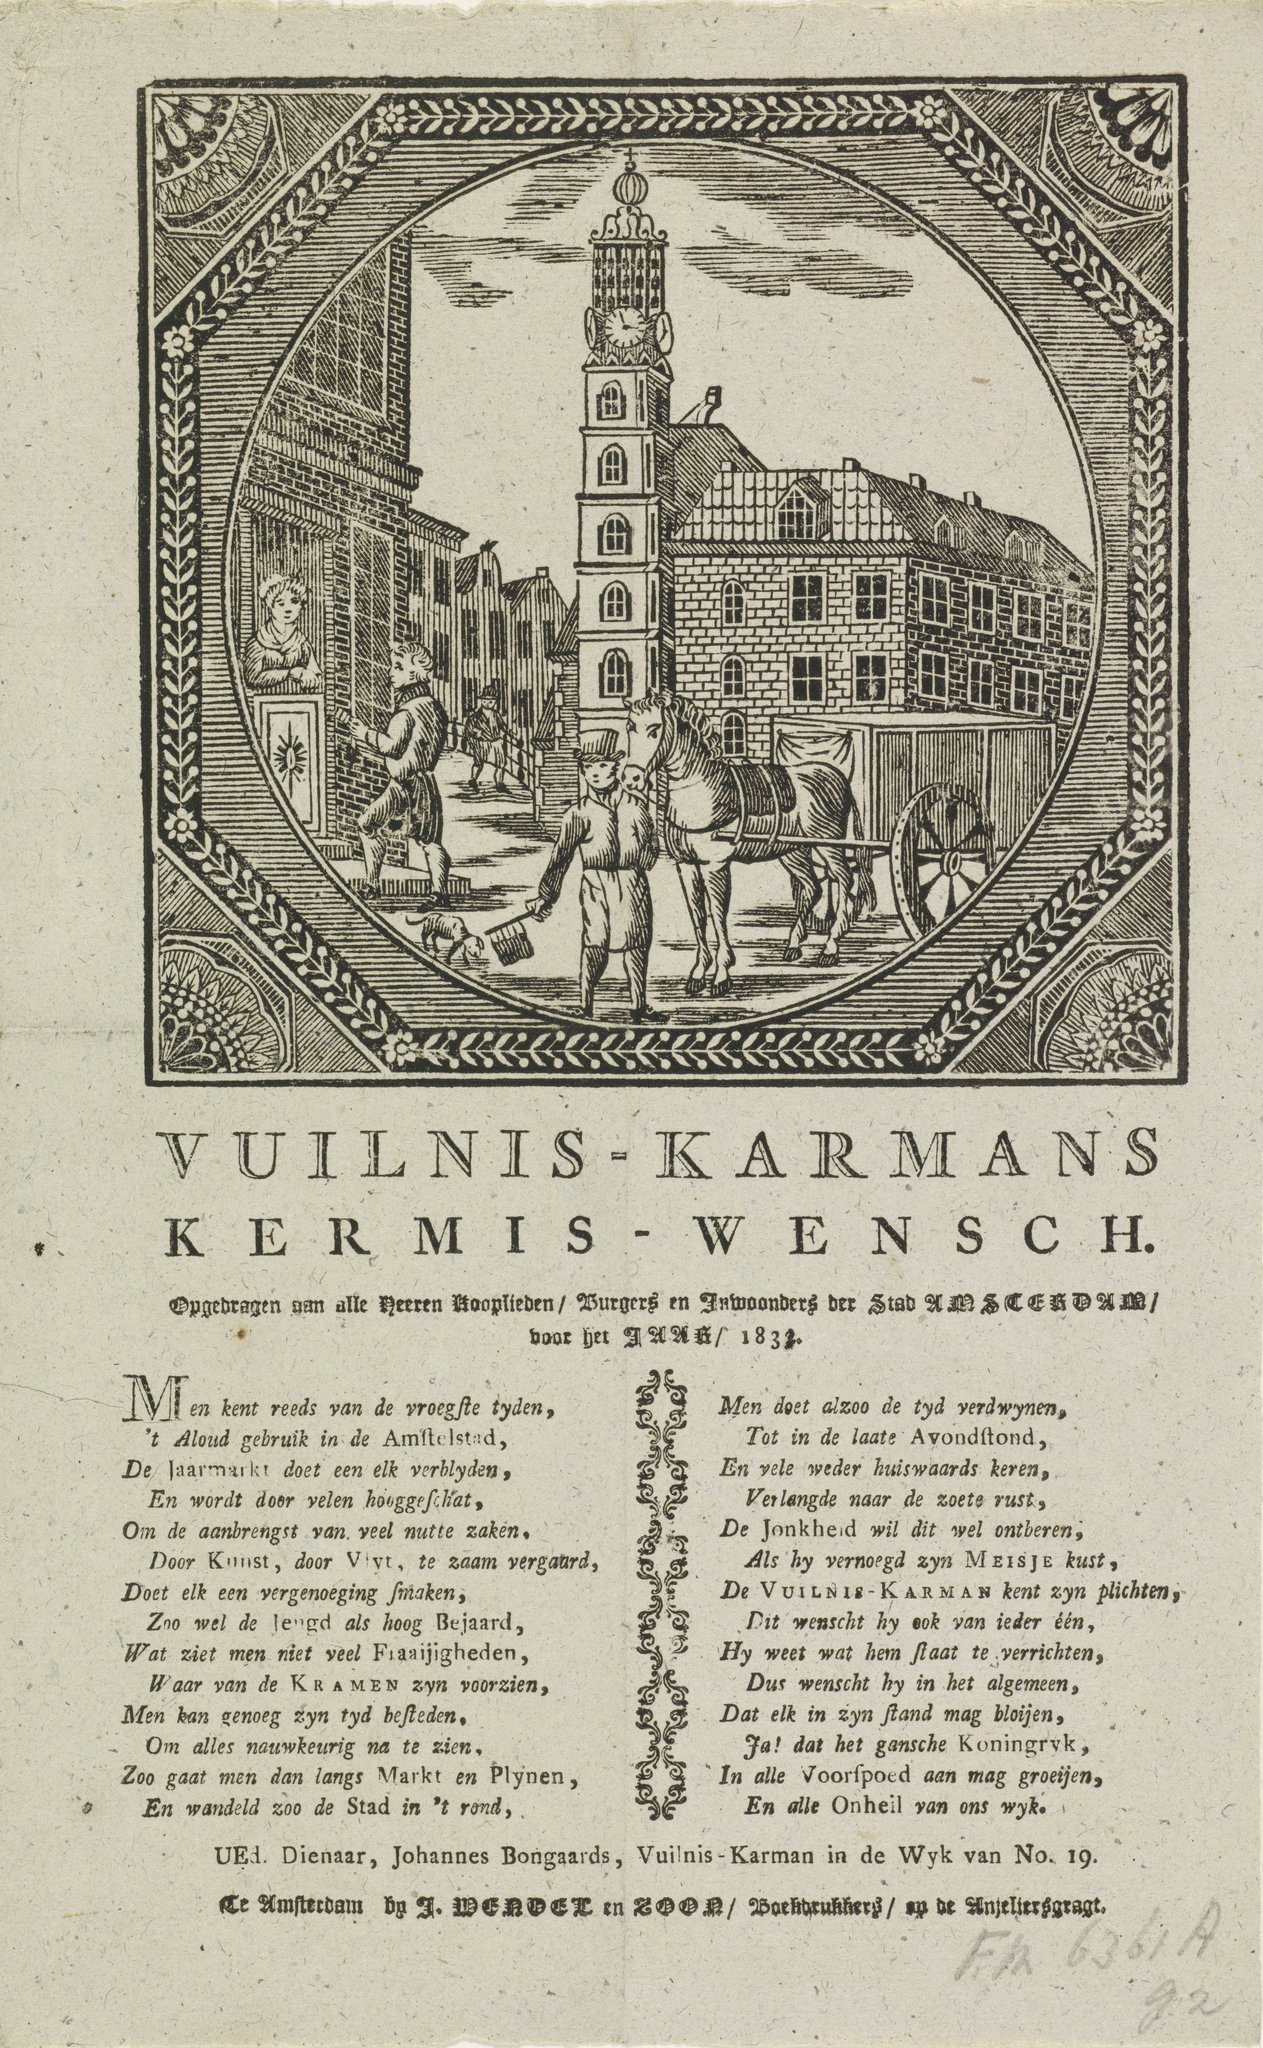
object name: fair print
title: Vuilnis-karmans kermis-wensch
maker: Anonymous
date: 1832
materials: paper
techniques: letterpress printing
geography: amsterdam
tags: street, garbage collection, amsterdam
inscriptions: collector's mark: Lugt 2228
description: Kermisprent van de Amsterdamse vuilnismannen voor het jaar 1832. Ronde voorstelling binnen achtkantige rand met een gezicht bij de Munt te Amsterdam waar een man met een ratel bij een vuilniskar staat. Een andere man haalt bij een huis geld op. Met gedicht in twee kolommen. Van de vuilniskarman in de wijk no. 19: Johannes Bongaards.